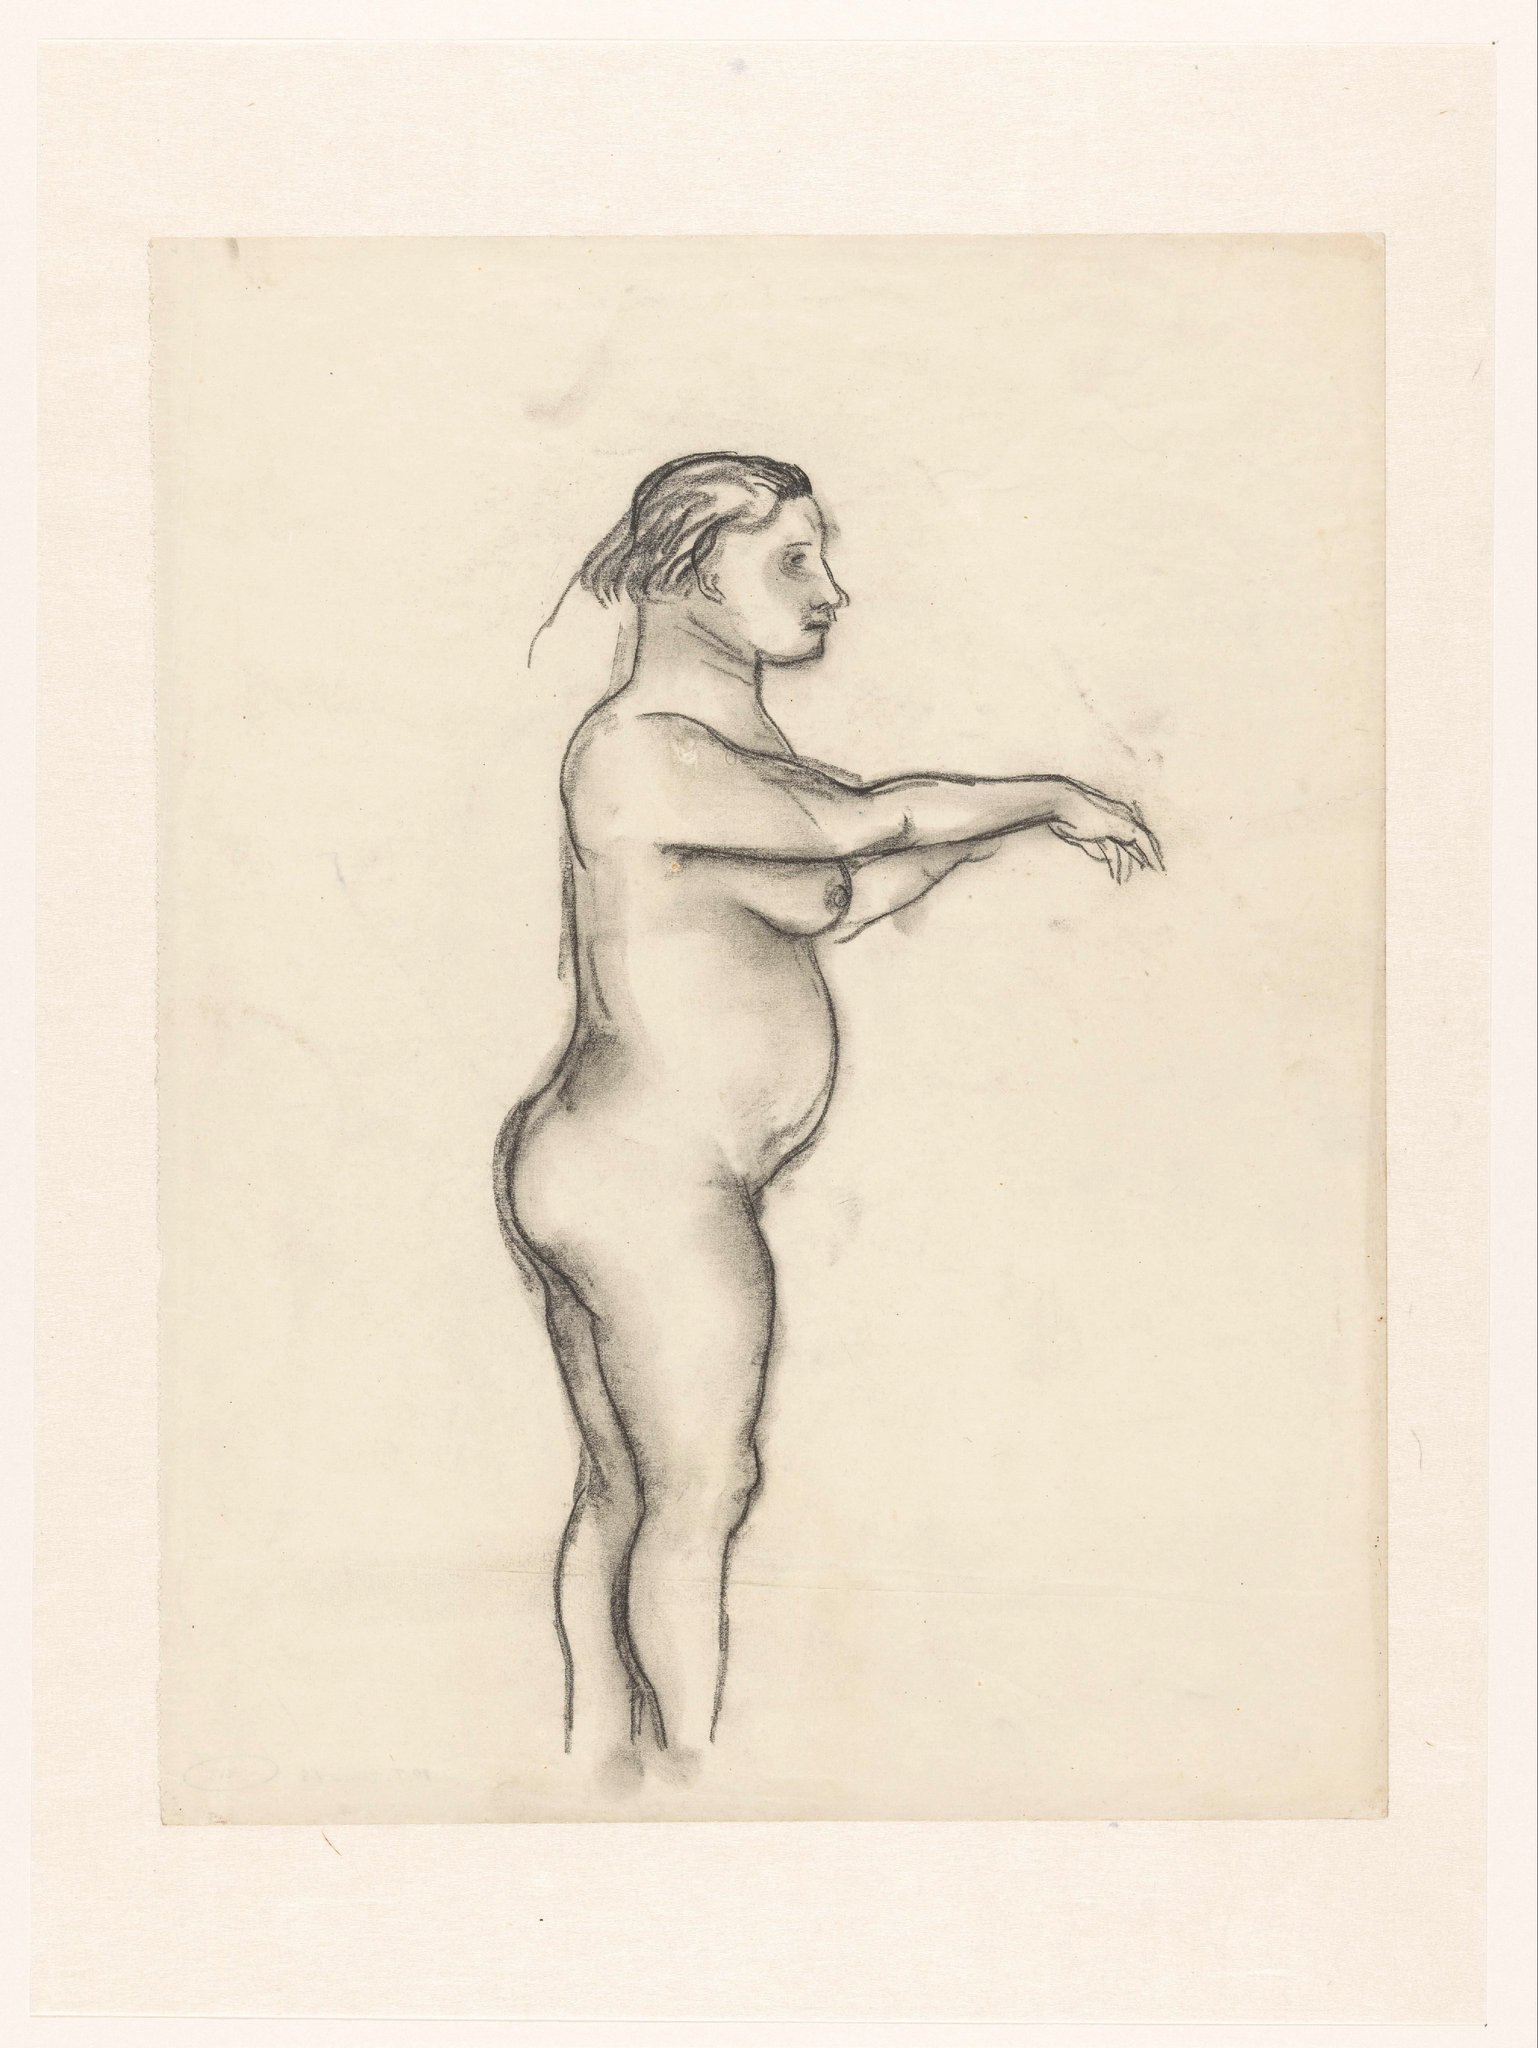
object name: drawing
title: Standing Female Nude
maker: henk henriët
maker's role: draughtsman, print maker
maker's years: 1903-1945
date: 1913-1945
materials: chalk, paper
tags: standing figure - aa - female human figure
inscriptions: collector's mark: Lugt 2228